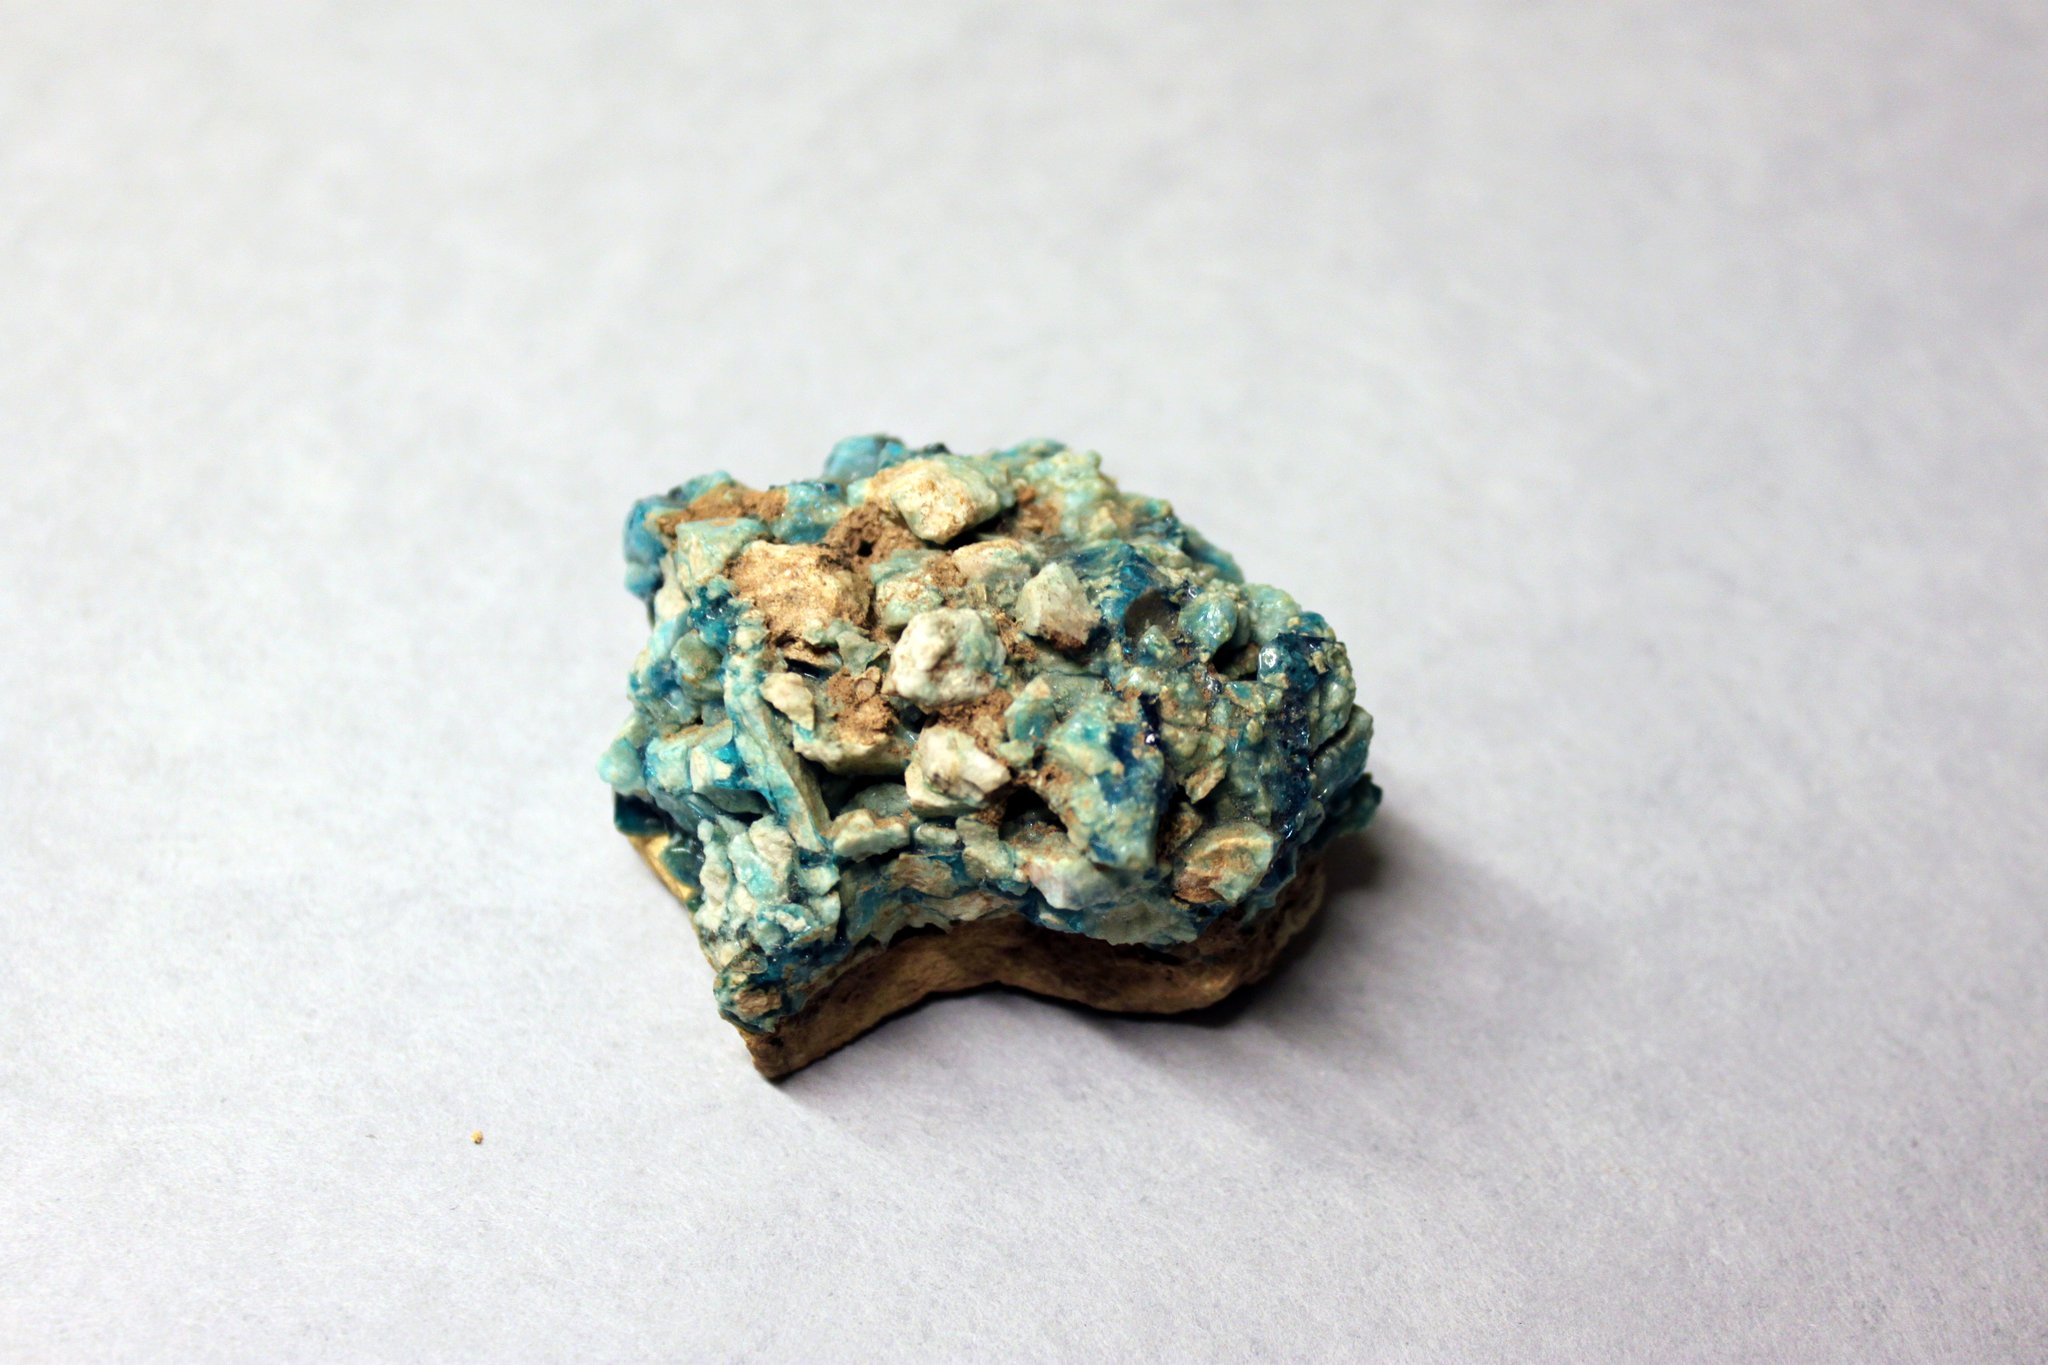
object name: glaze clump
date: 1001-1200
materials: copper, earthenware, glaze, quartz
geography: iran